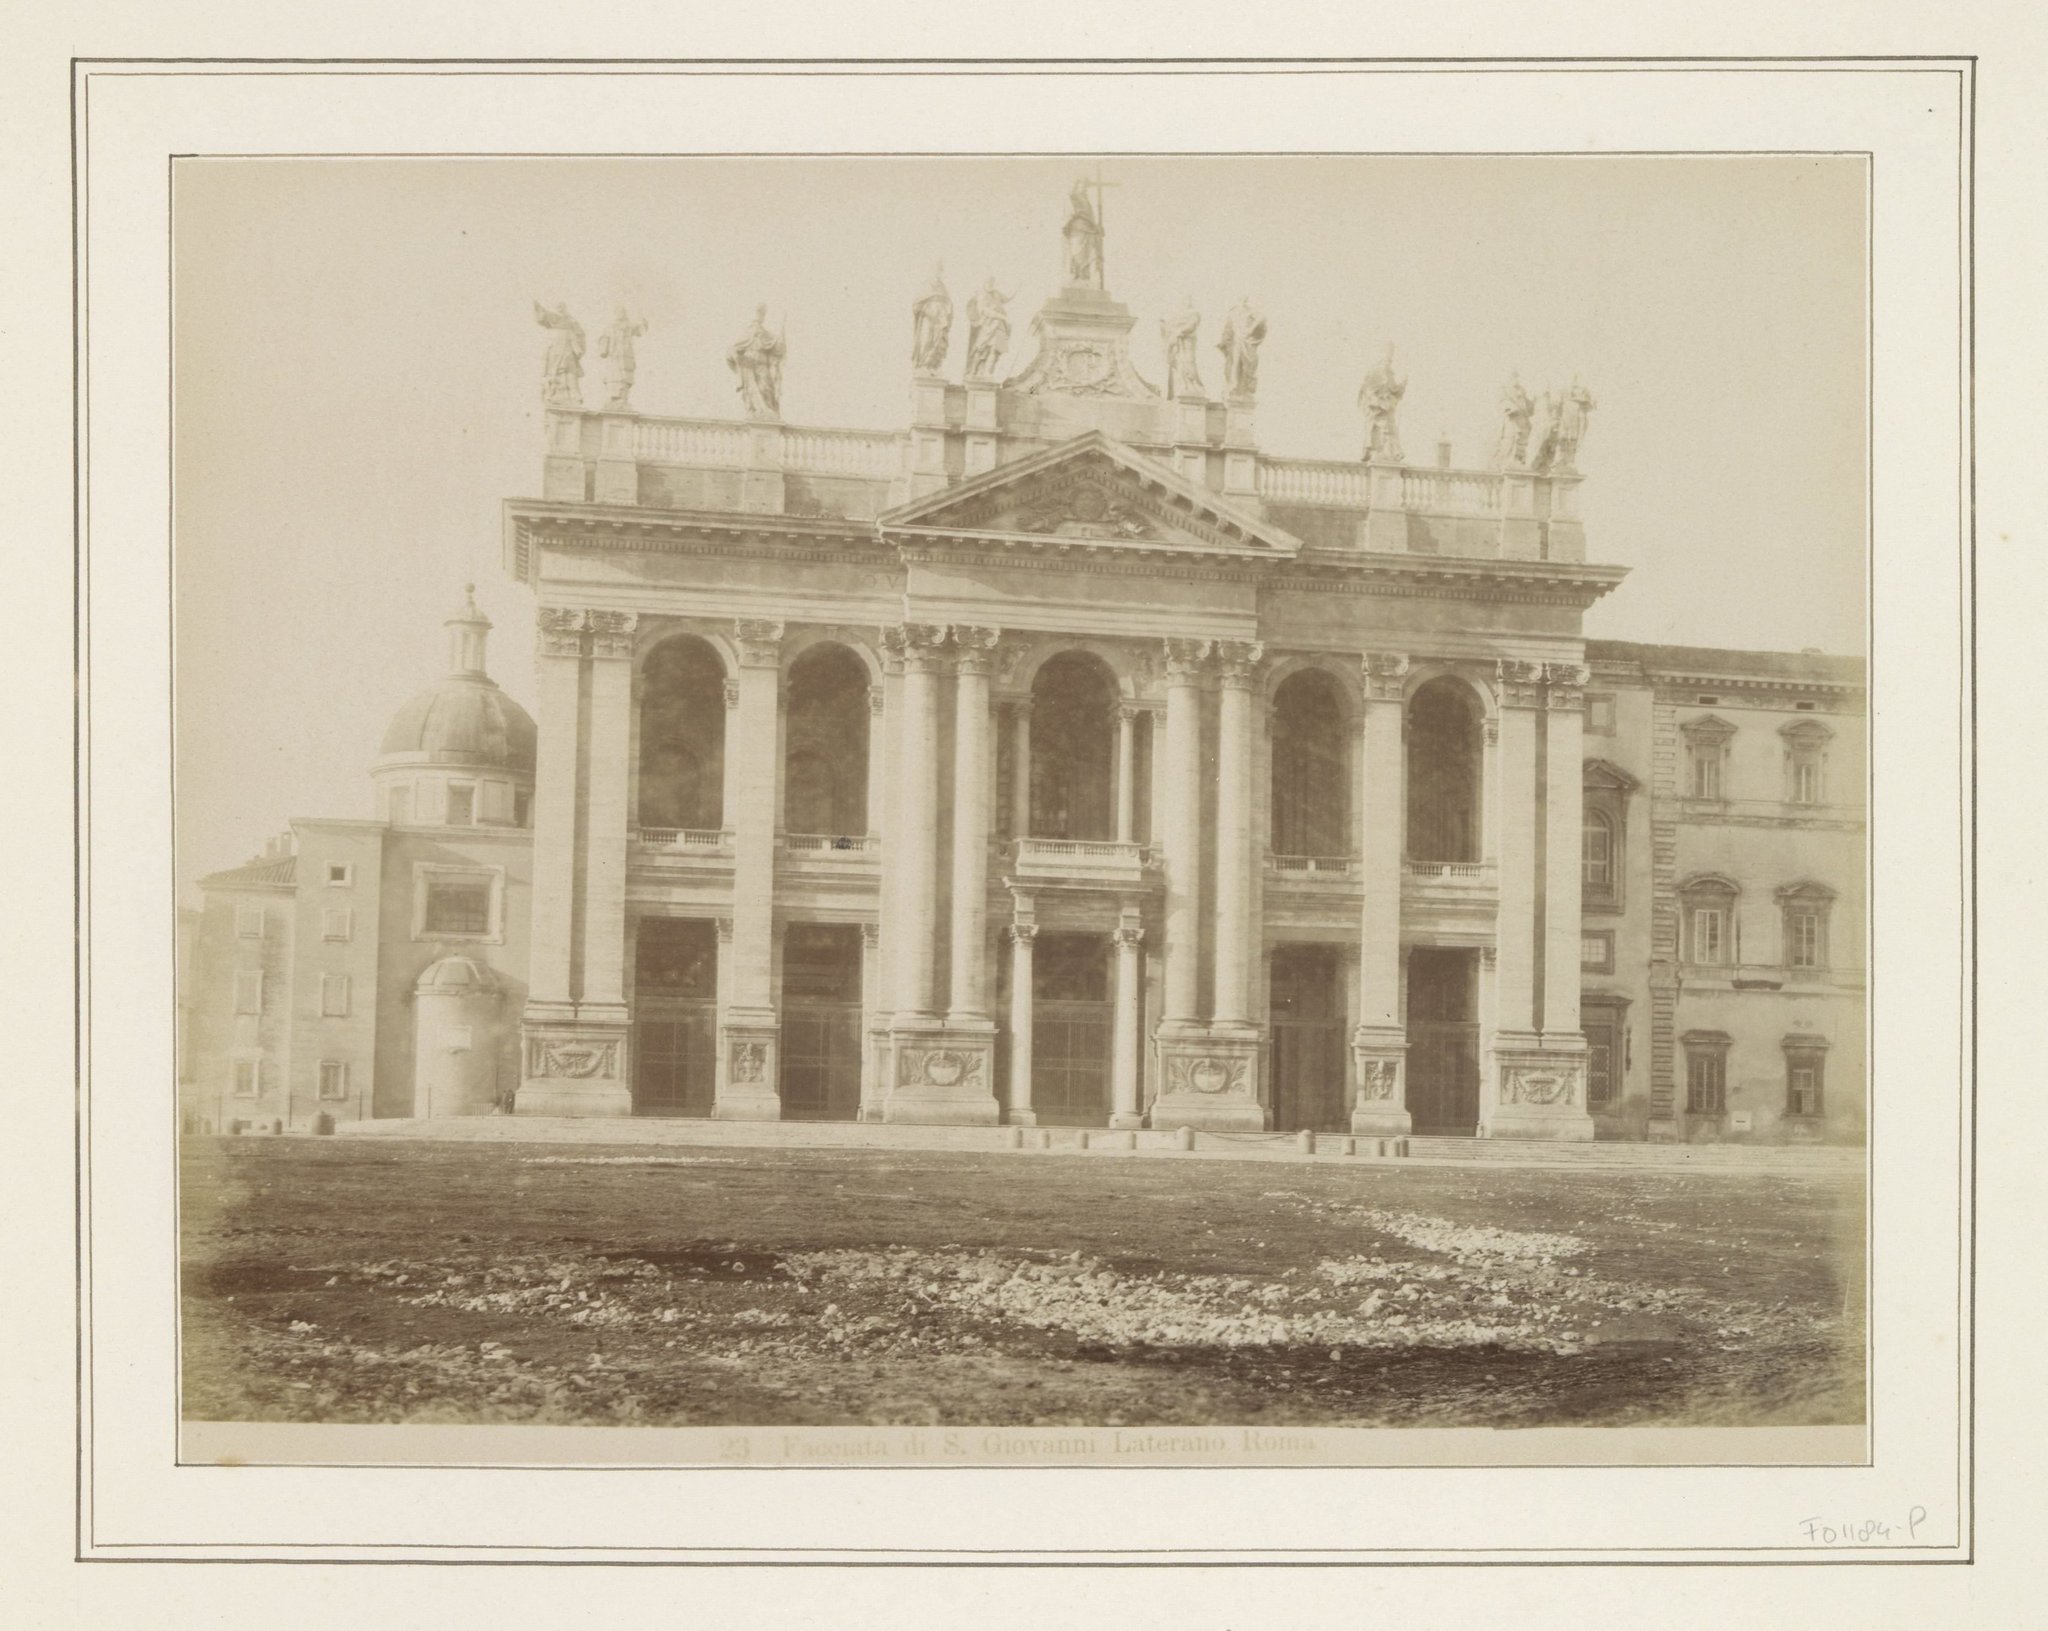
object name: photograph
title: Gevel van de Sint-Jan van Lateranen te Rome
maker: Anonymous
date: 1865-1890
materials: paper, photographic support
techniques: albumen print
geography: rome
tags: church (exterior), façade (of house or building)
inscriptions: negative number: ‘23’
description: Onderdeel van Reisalbum met foto's van bezienswaardigheden in Italië (deel I).